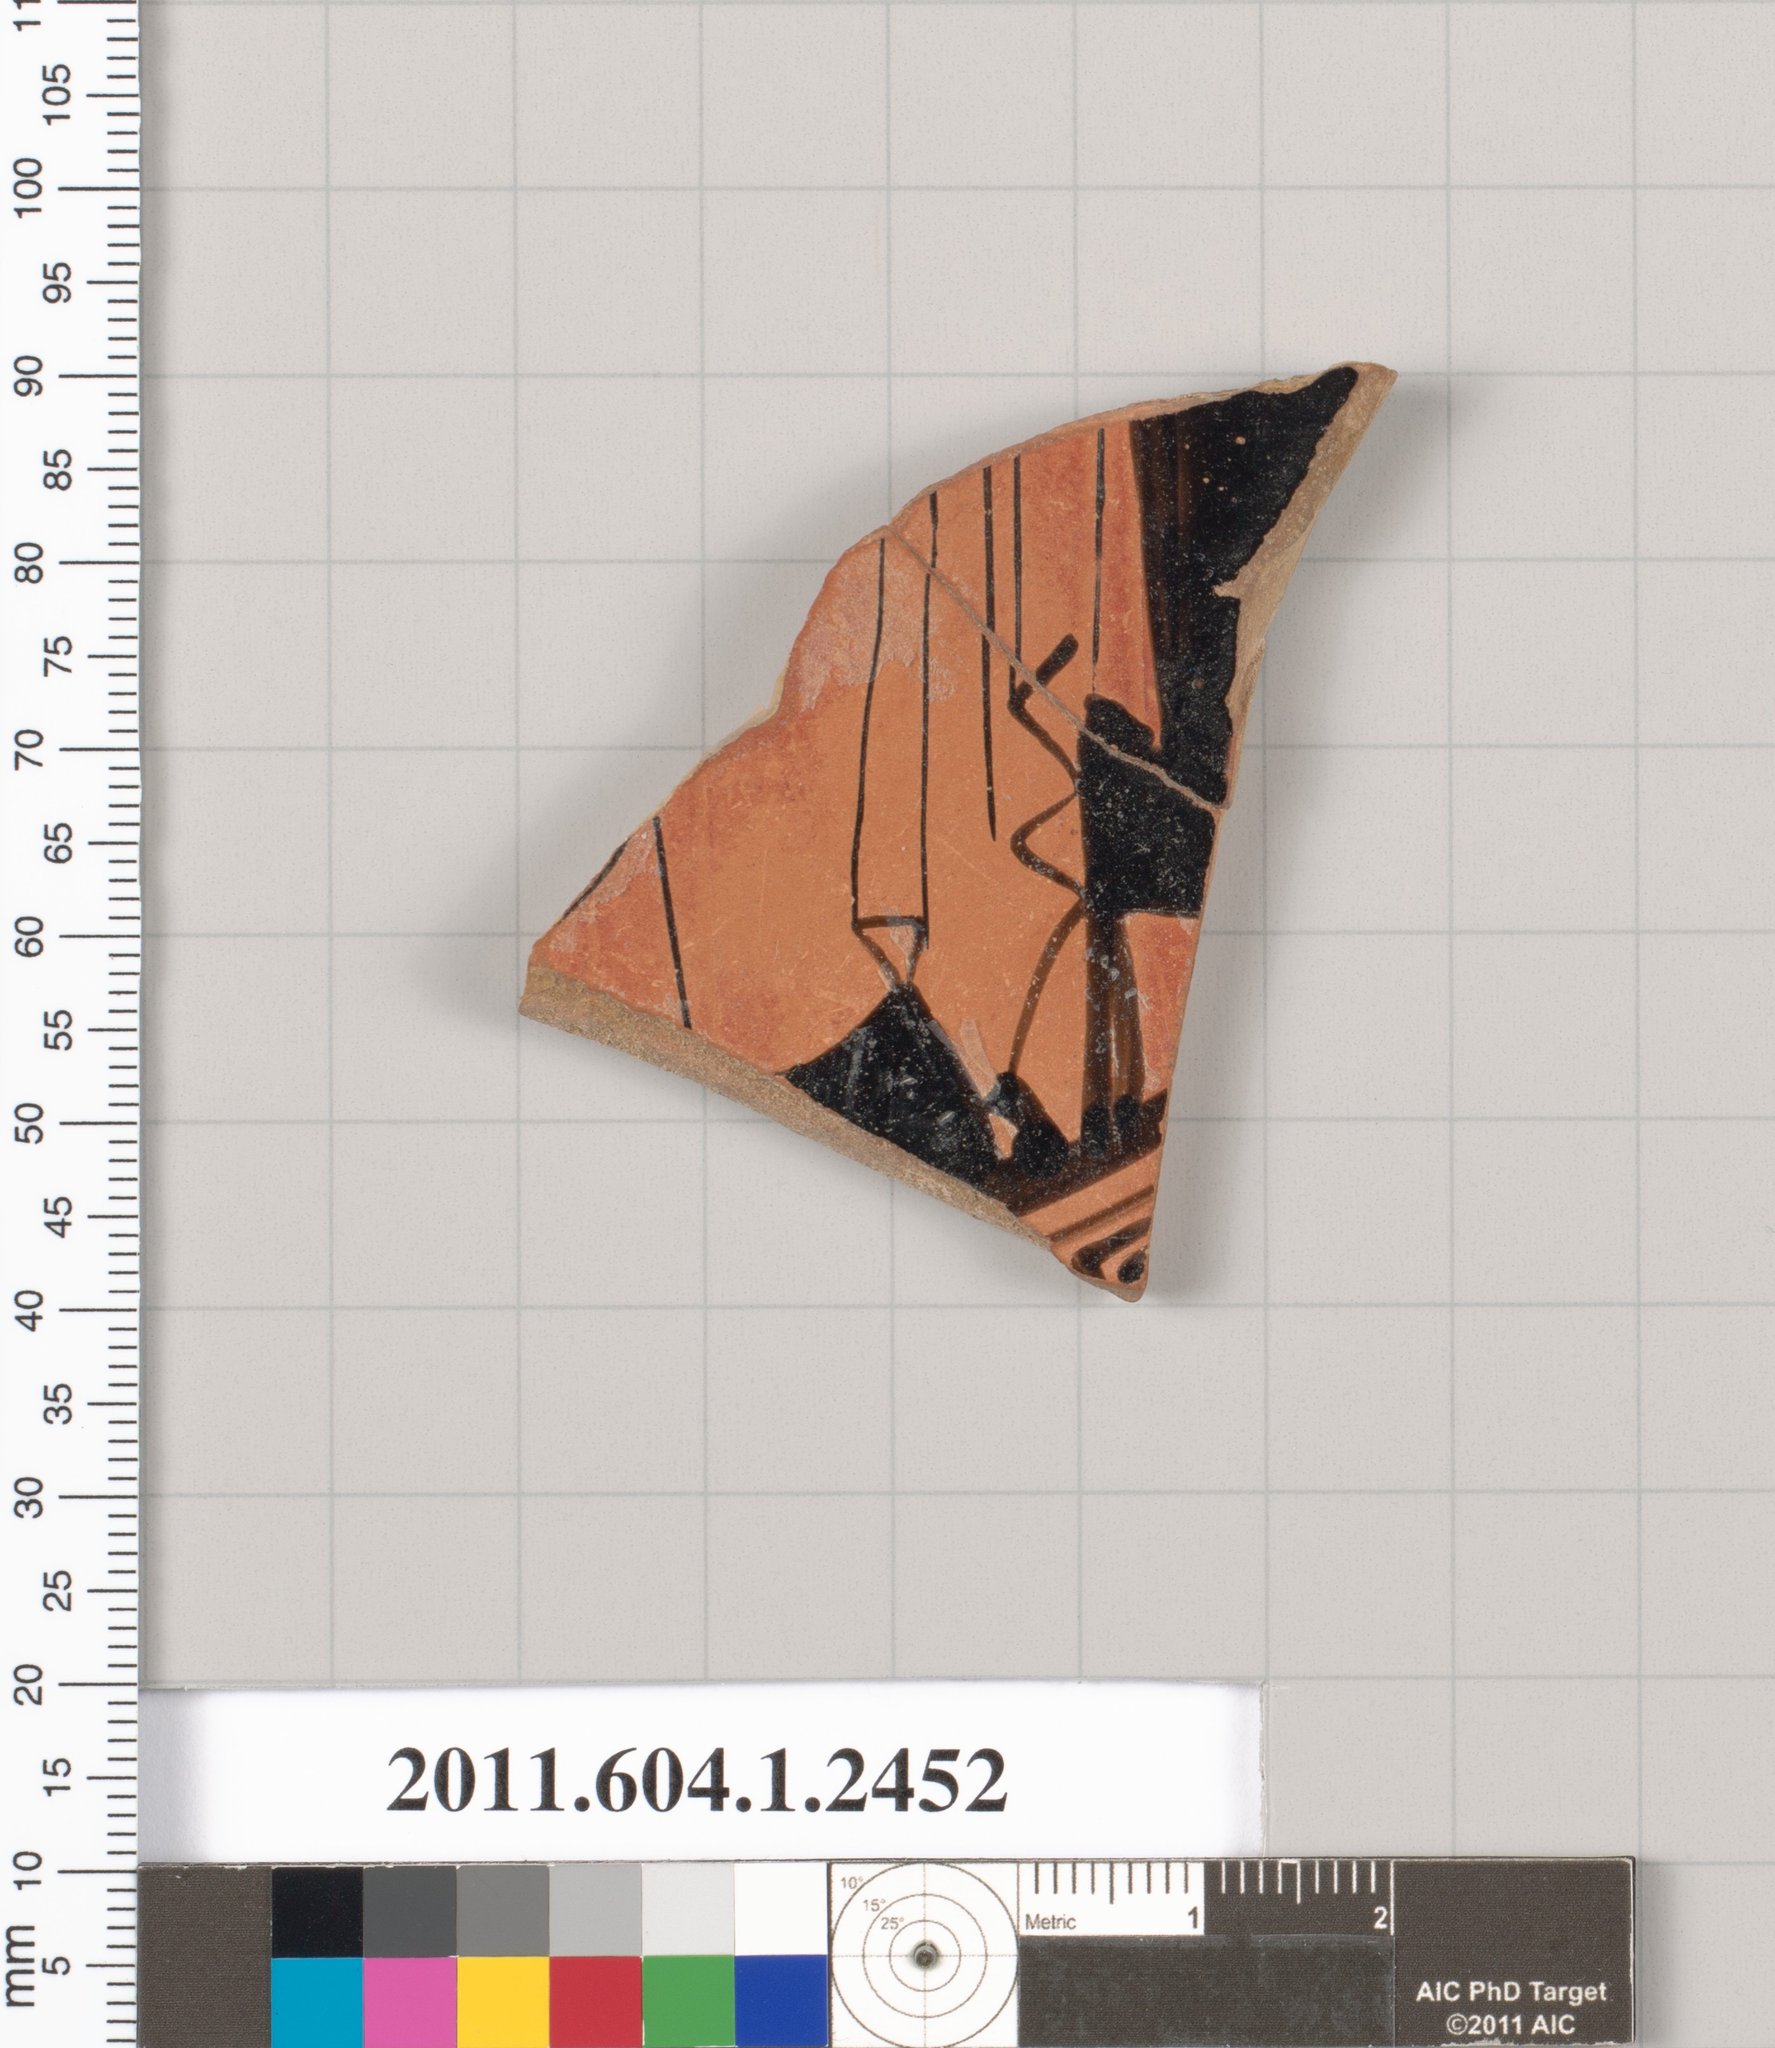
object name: kylix fragment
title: Terracotta fragment of a kylix (drinking cup)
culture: greek, attic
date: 475-451 BCE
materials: terracotta